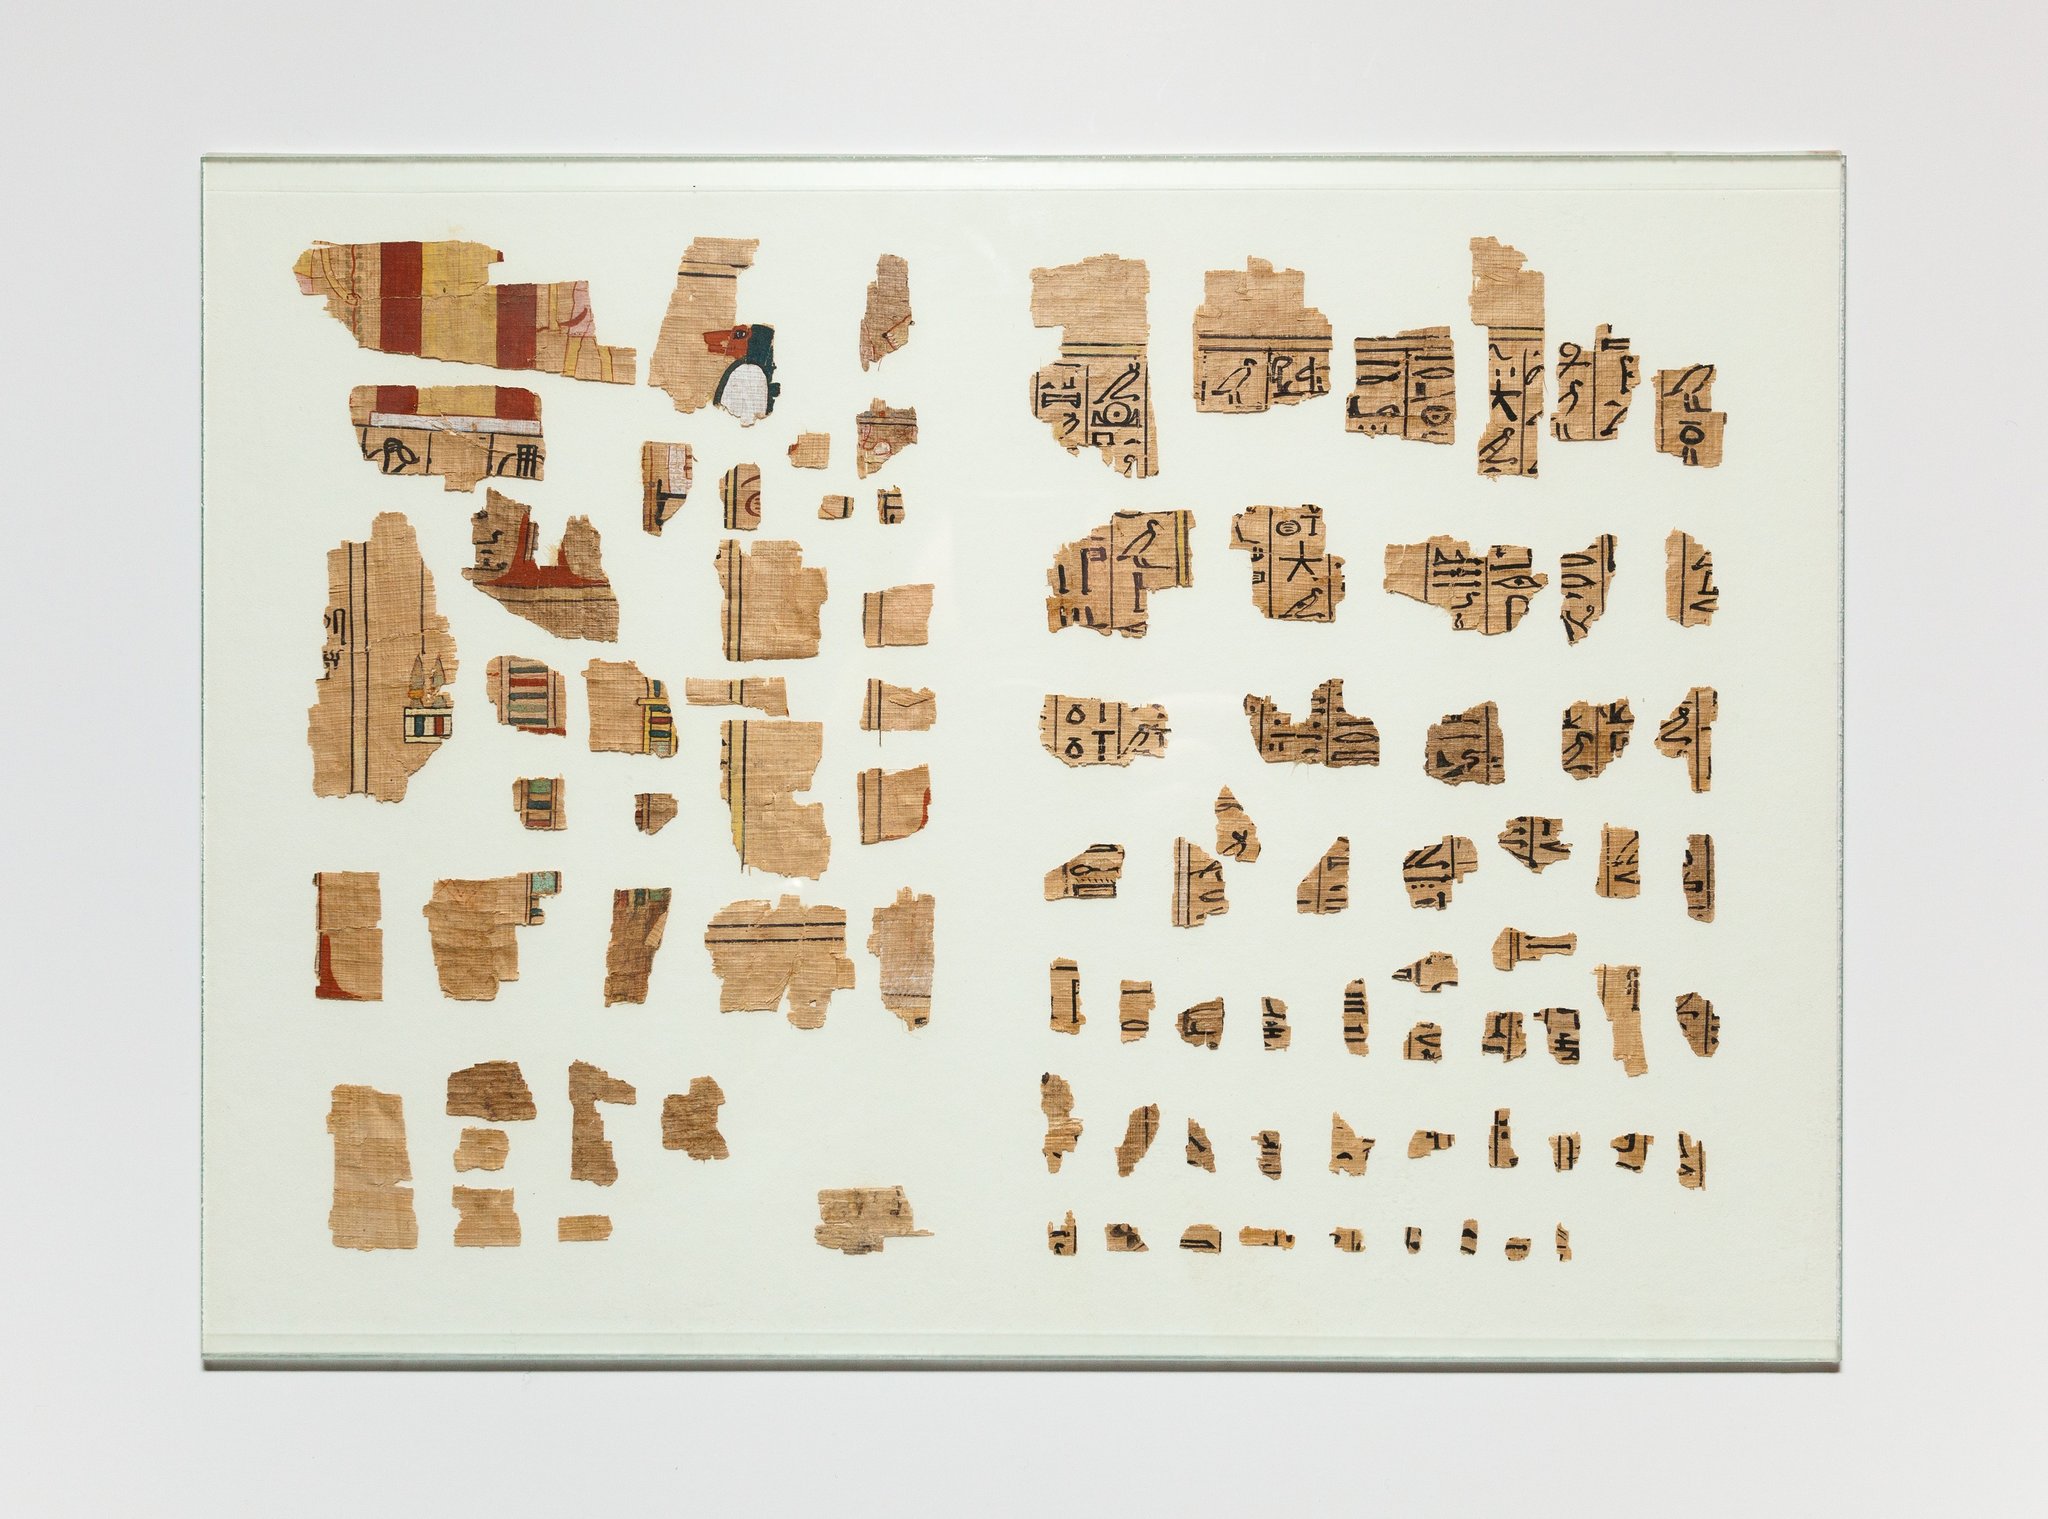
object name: papyrus, funerary, book of the dead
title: Fragments from a Book of the Dead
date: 1295-1070 BCE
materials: ink, papyrus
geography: egypt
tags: hieroglyphs